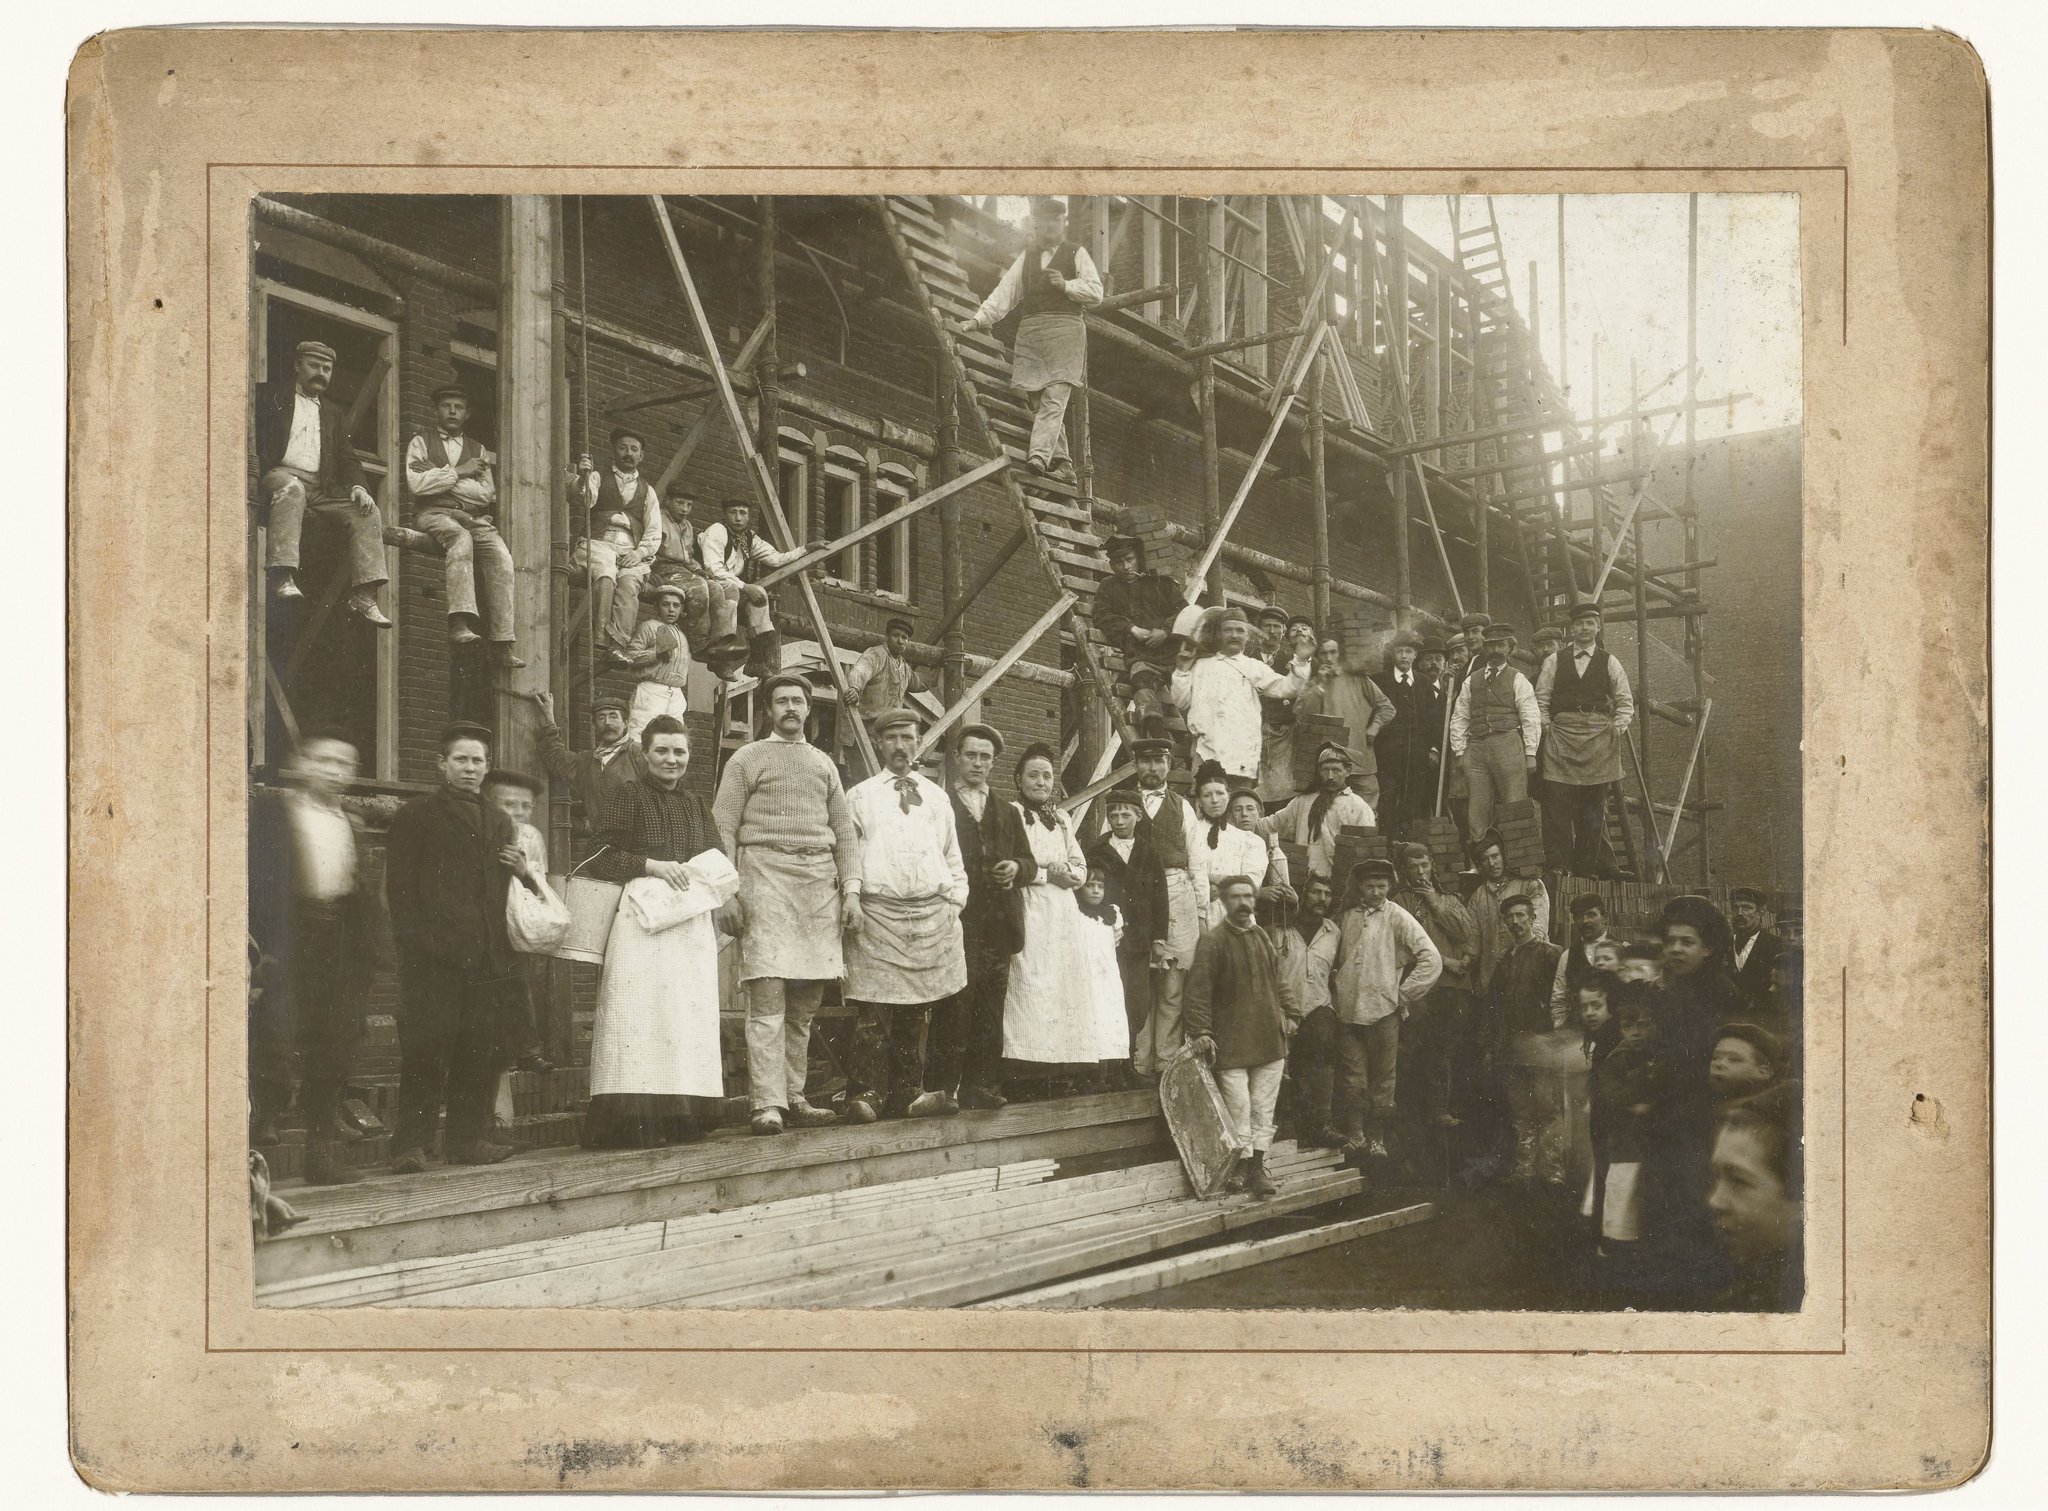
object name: photograph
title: Groepsportret van arbeiders bij een huis in aanbouw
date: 1890-1910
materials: cardboard, paper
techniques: gelatin silver print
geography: amsterdam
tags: anonymous historical persons portrayed in a group, in a group-portrait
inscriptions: signature: ‘Centraal photographie atelier, Niewendijk No 108’